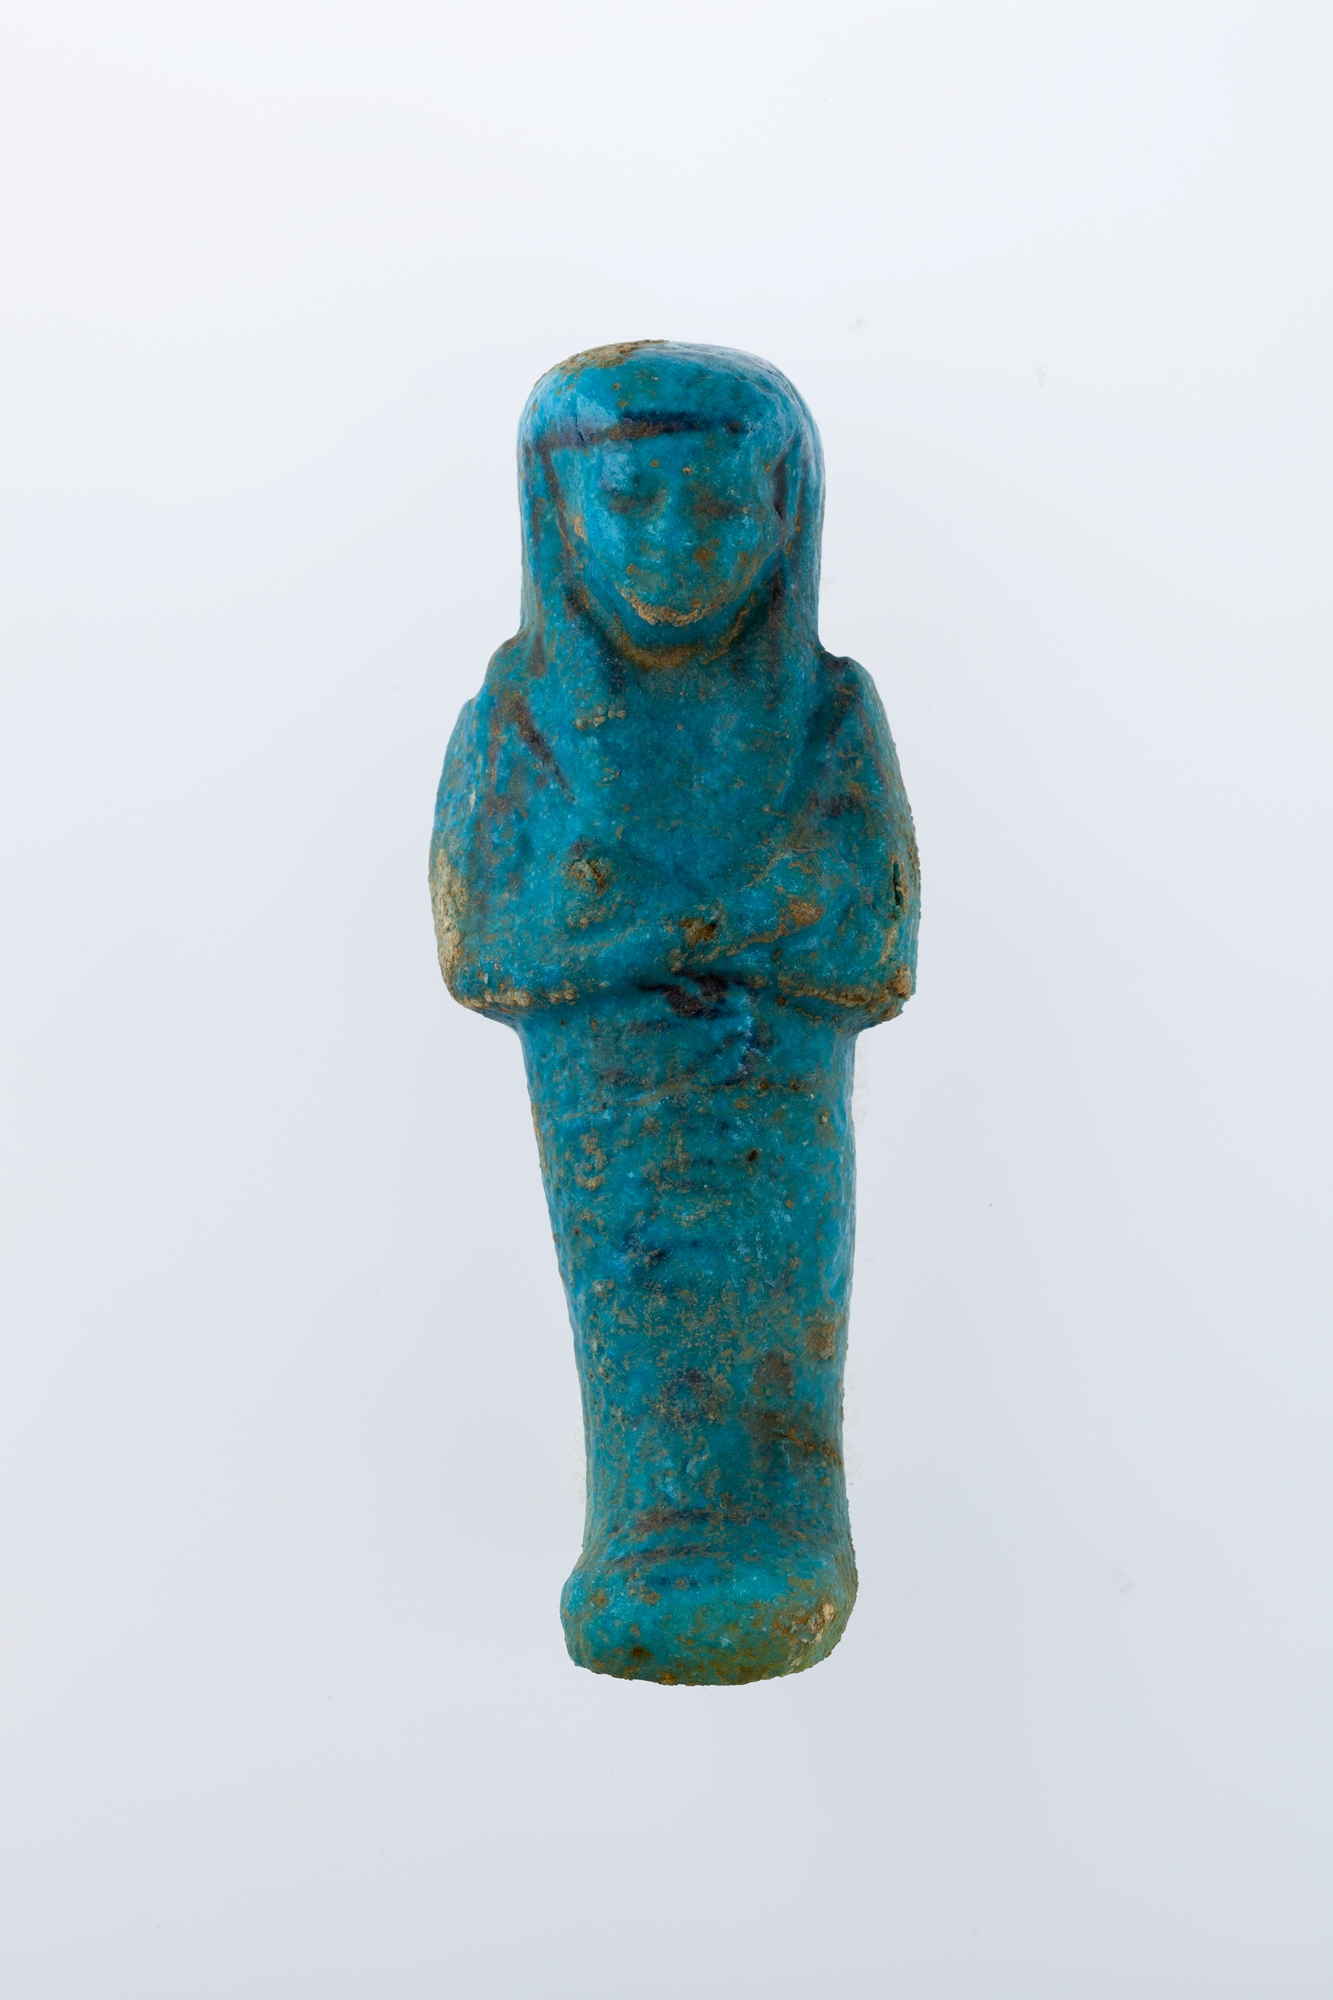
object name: shabti, henettawy c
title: Worker Shabti of Henettawy (C), Daughter of Isetemkheb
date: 990-970 BCE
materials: faience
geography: egypt